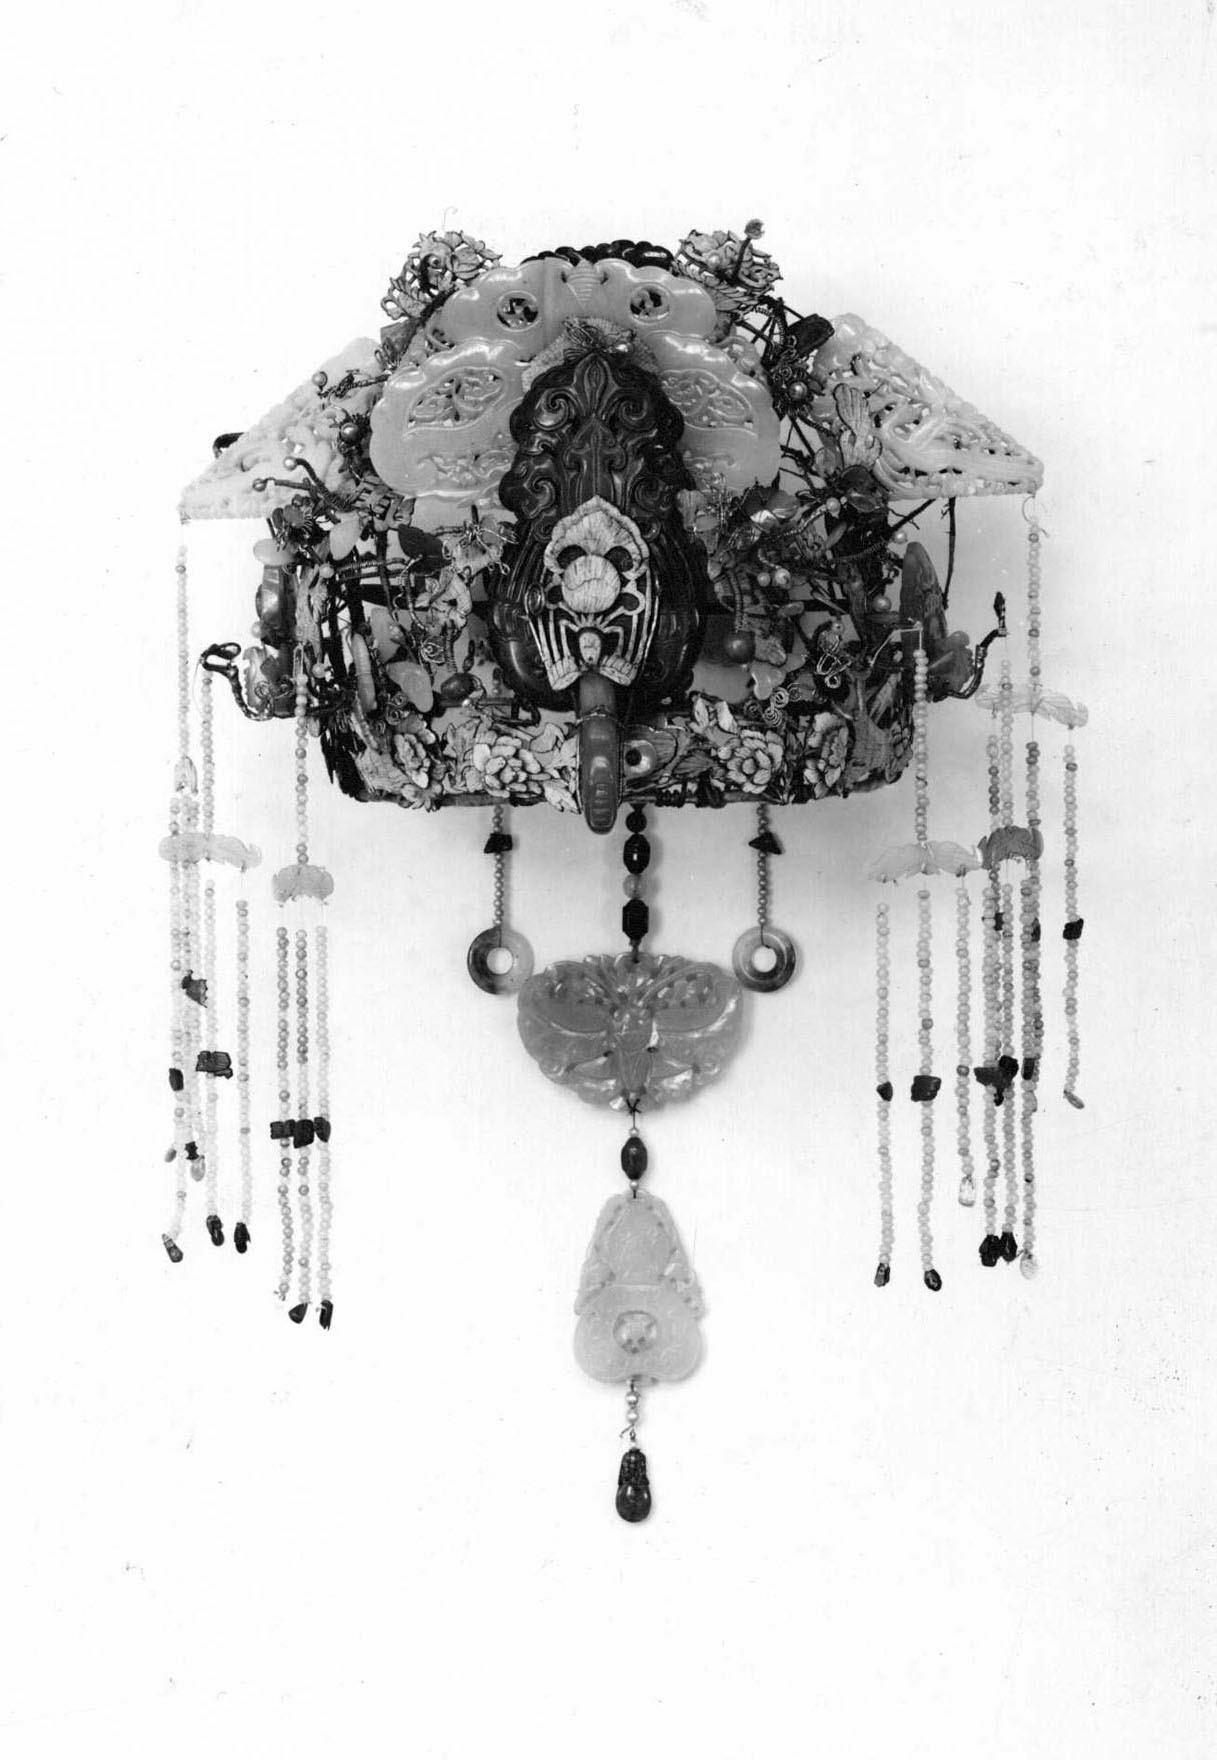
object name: headdress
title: Theatrical Headdress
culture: chinese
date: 1701-1800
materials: amber, gemstone, coral, feather, gilt, glass, jade, pearl, metal